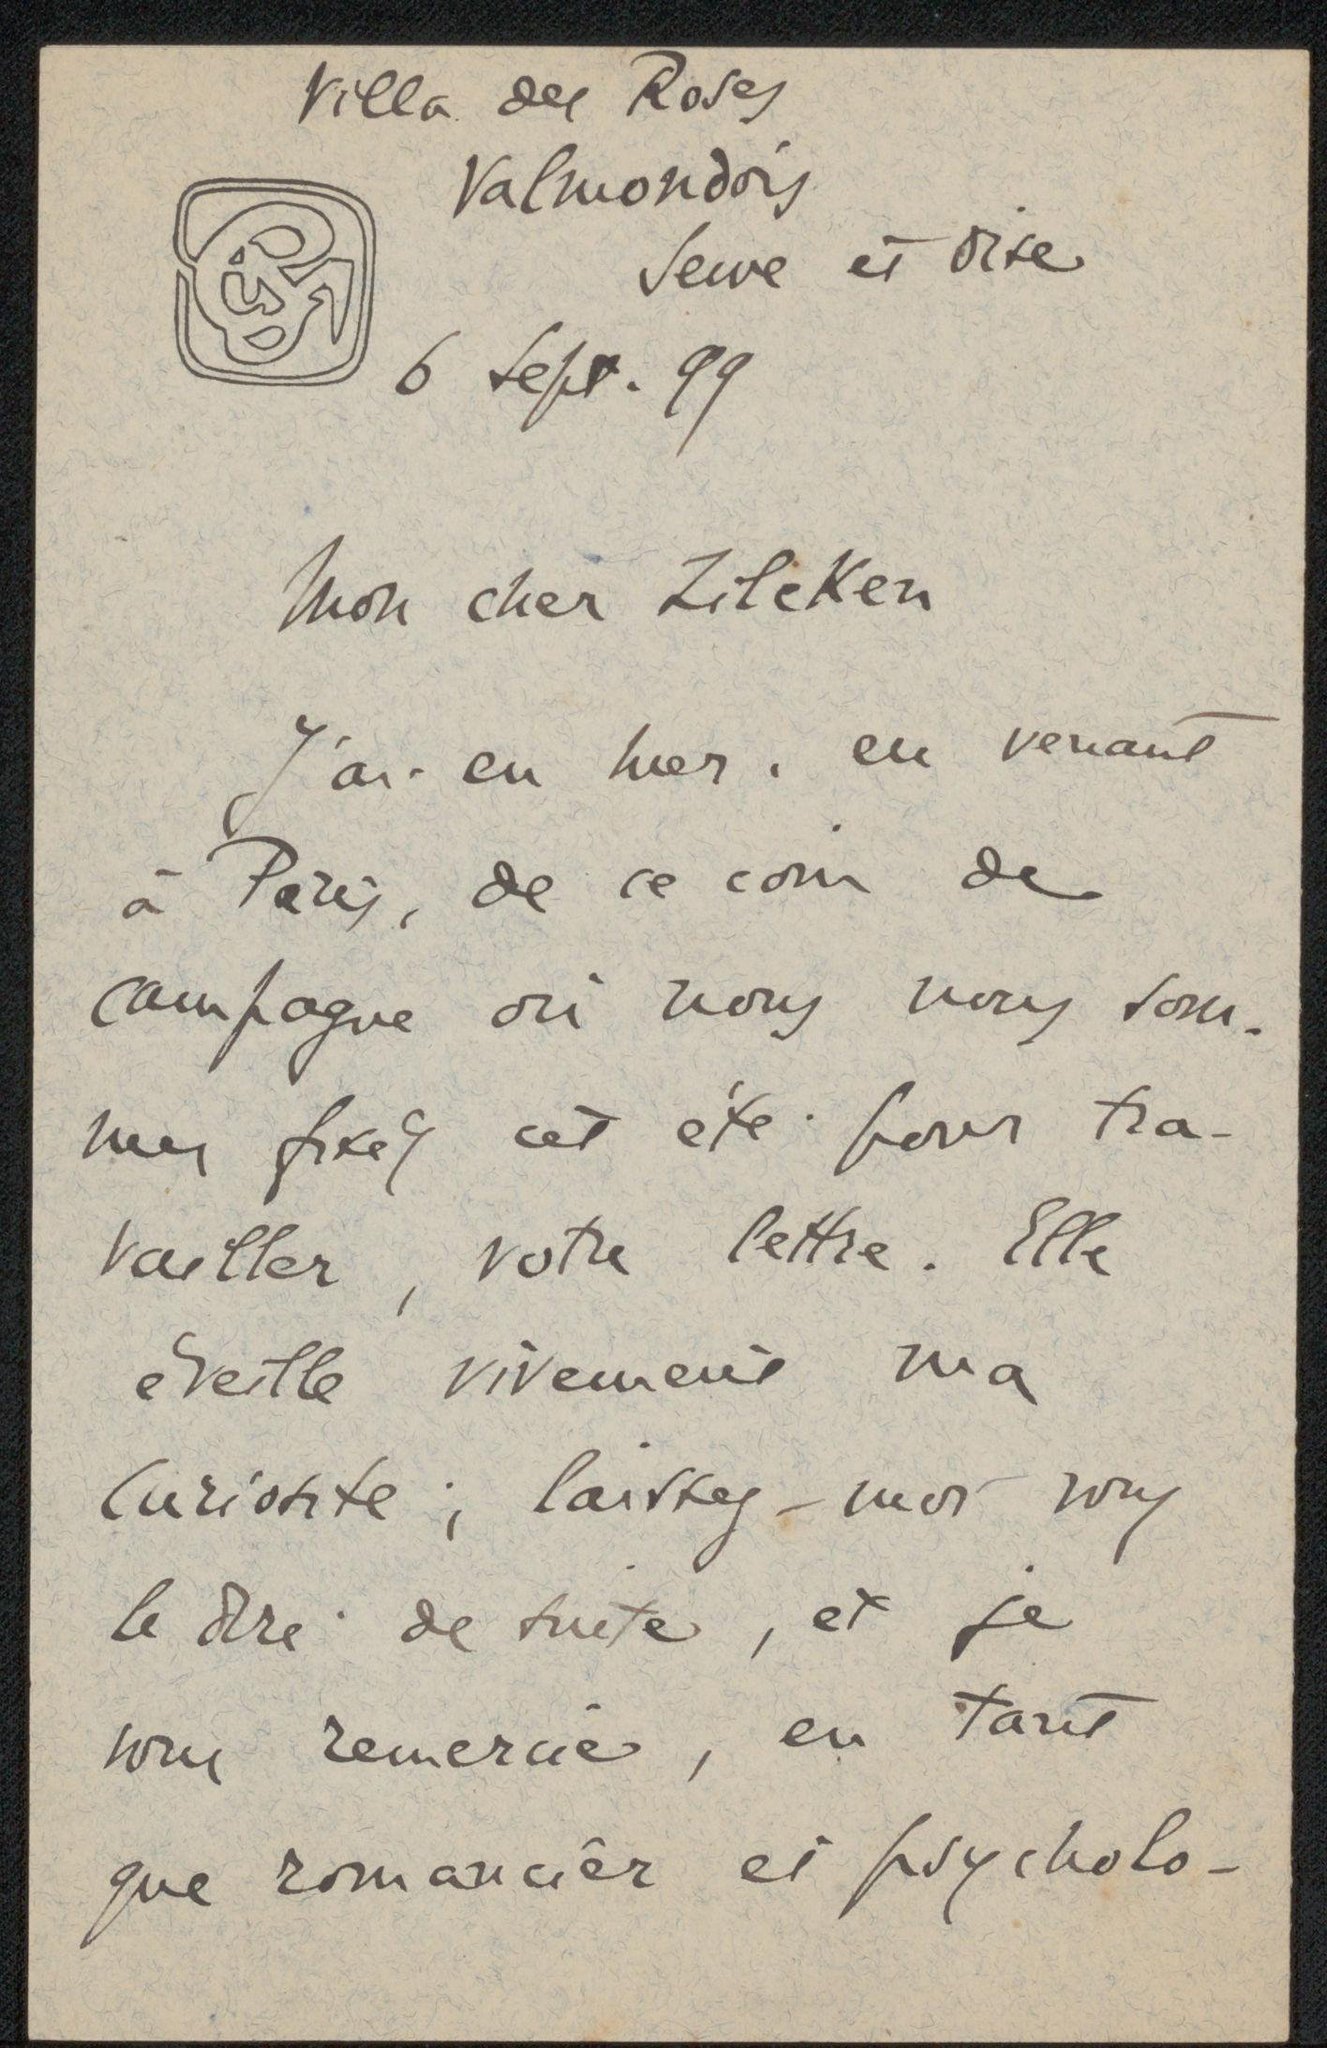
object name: letter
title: Brief aan Philip Zilcken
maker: gabriel mourey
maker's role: criticus, schrijver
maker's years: 1865-1943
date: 1899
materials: ink, paper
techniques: pen, printing, writing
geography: valmondois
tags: the hague, painter, draughtsman, philip zilcken, paris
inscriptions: collector's mark: ‘RPK’